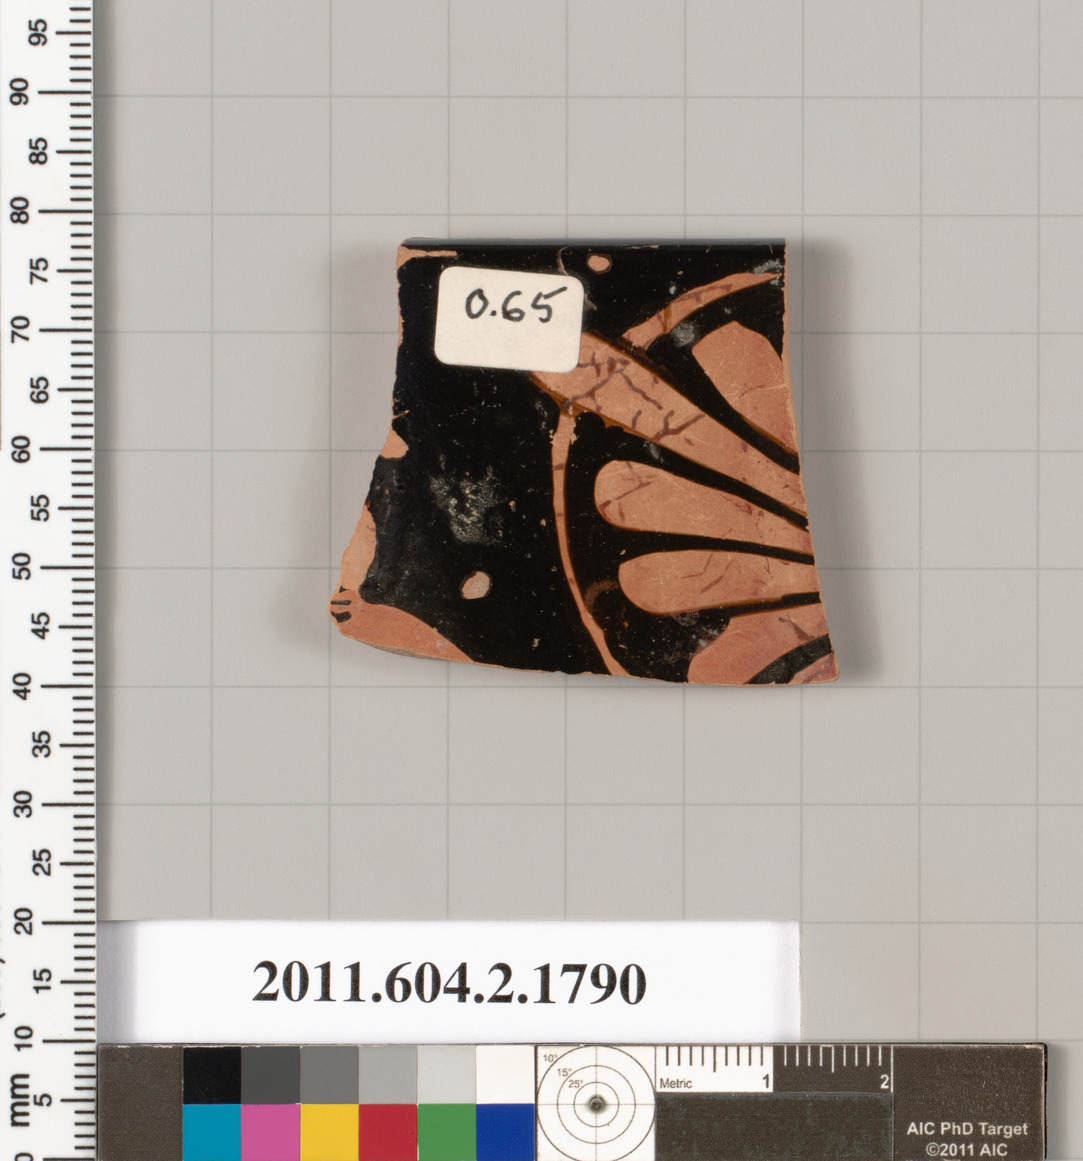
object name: skyphos fragment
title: Terracotta rim fragment of a skyphos (deep drinking cup)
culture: greek, attic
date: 470-450 BCE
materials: terracotta